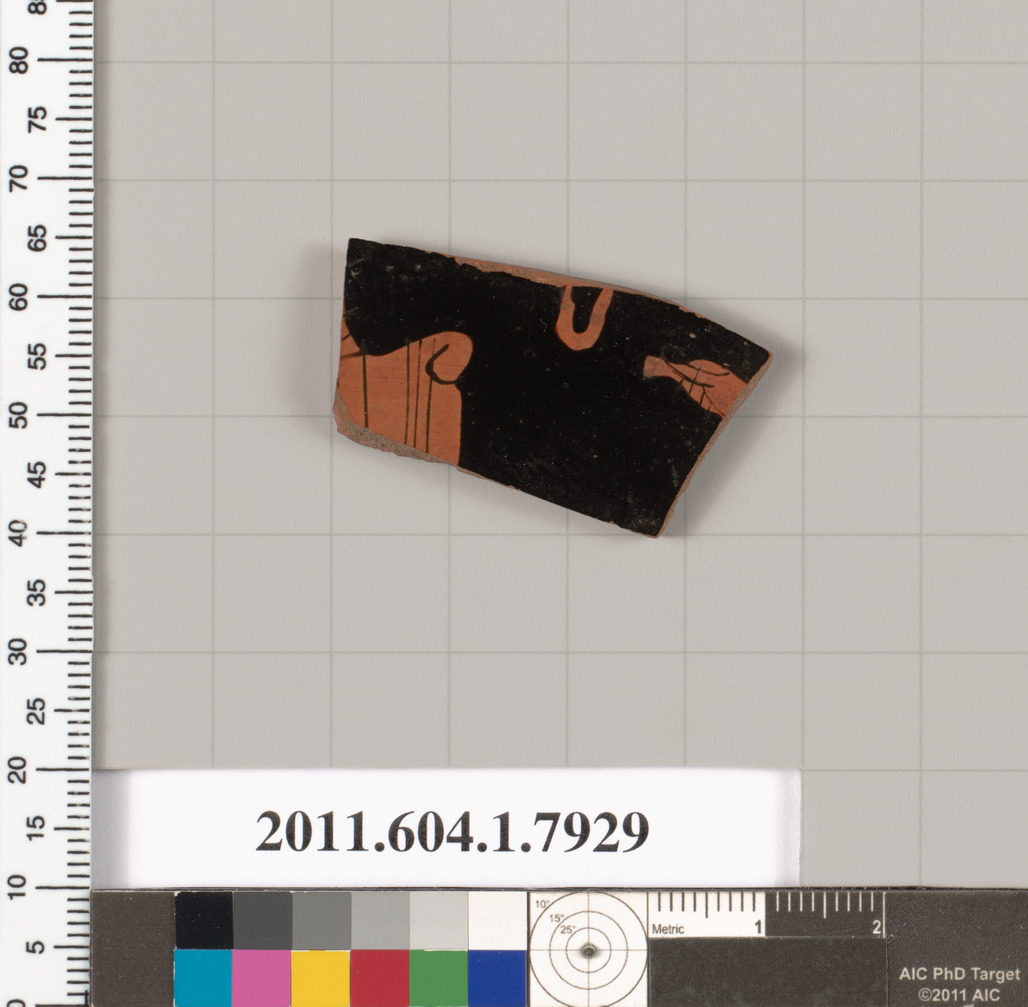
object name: kylix fragment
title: Terracotta fragment of a kylix (drinking cup)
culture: greek, attic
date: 460-450 BCE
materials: terracotta